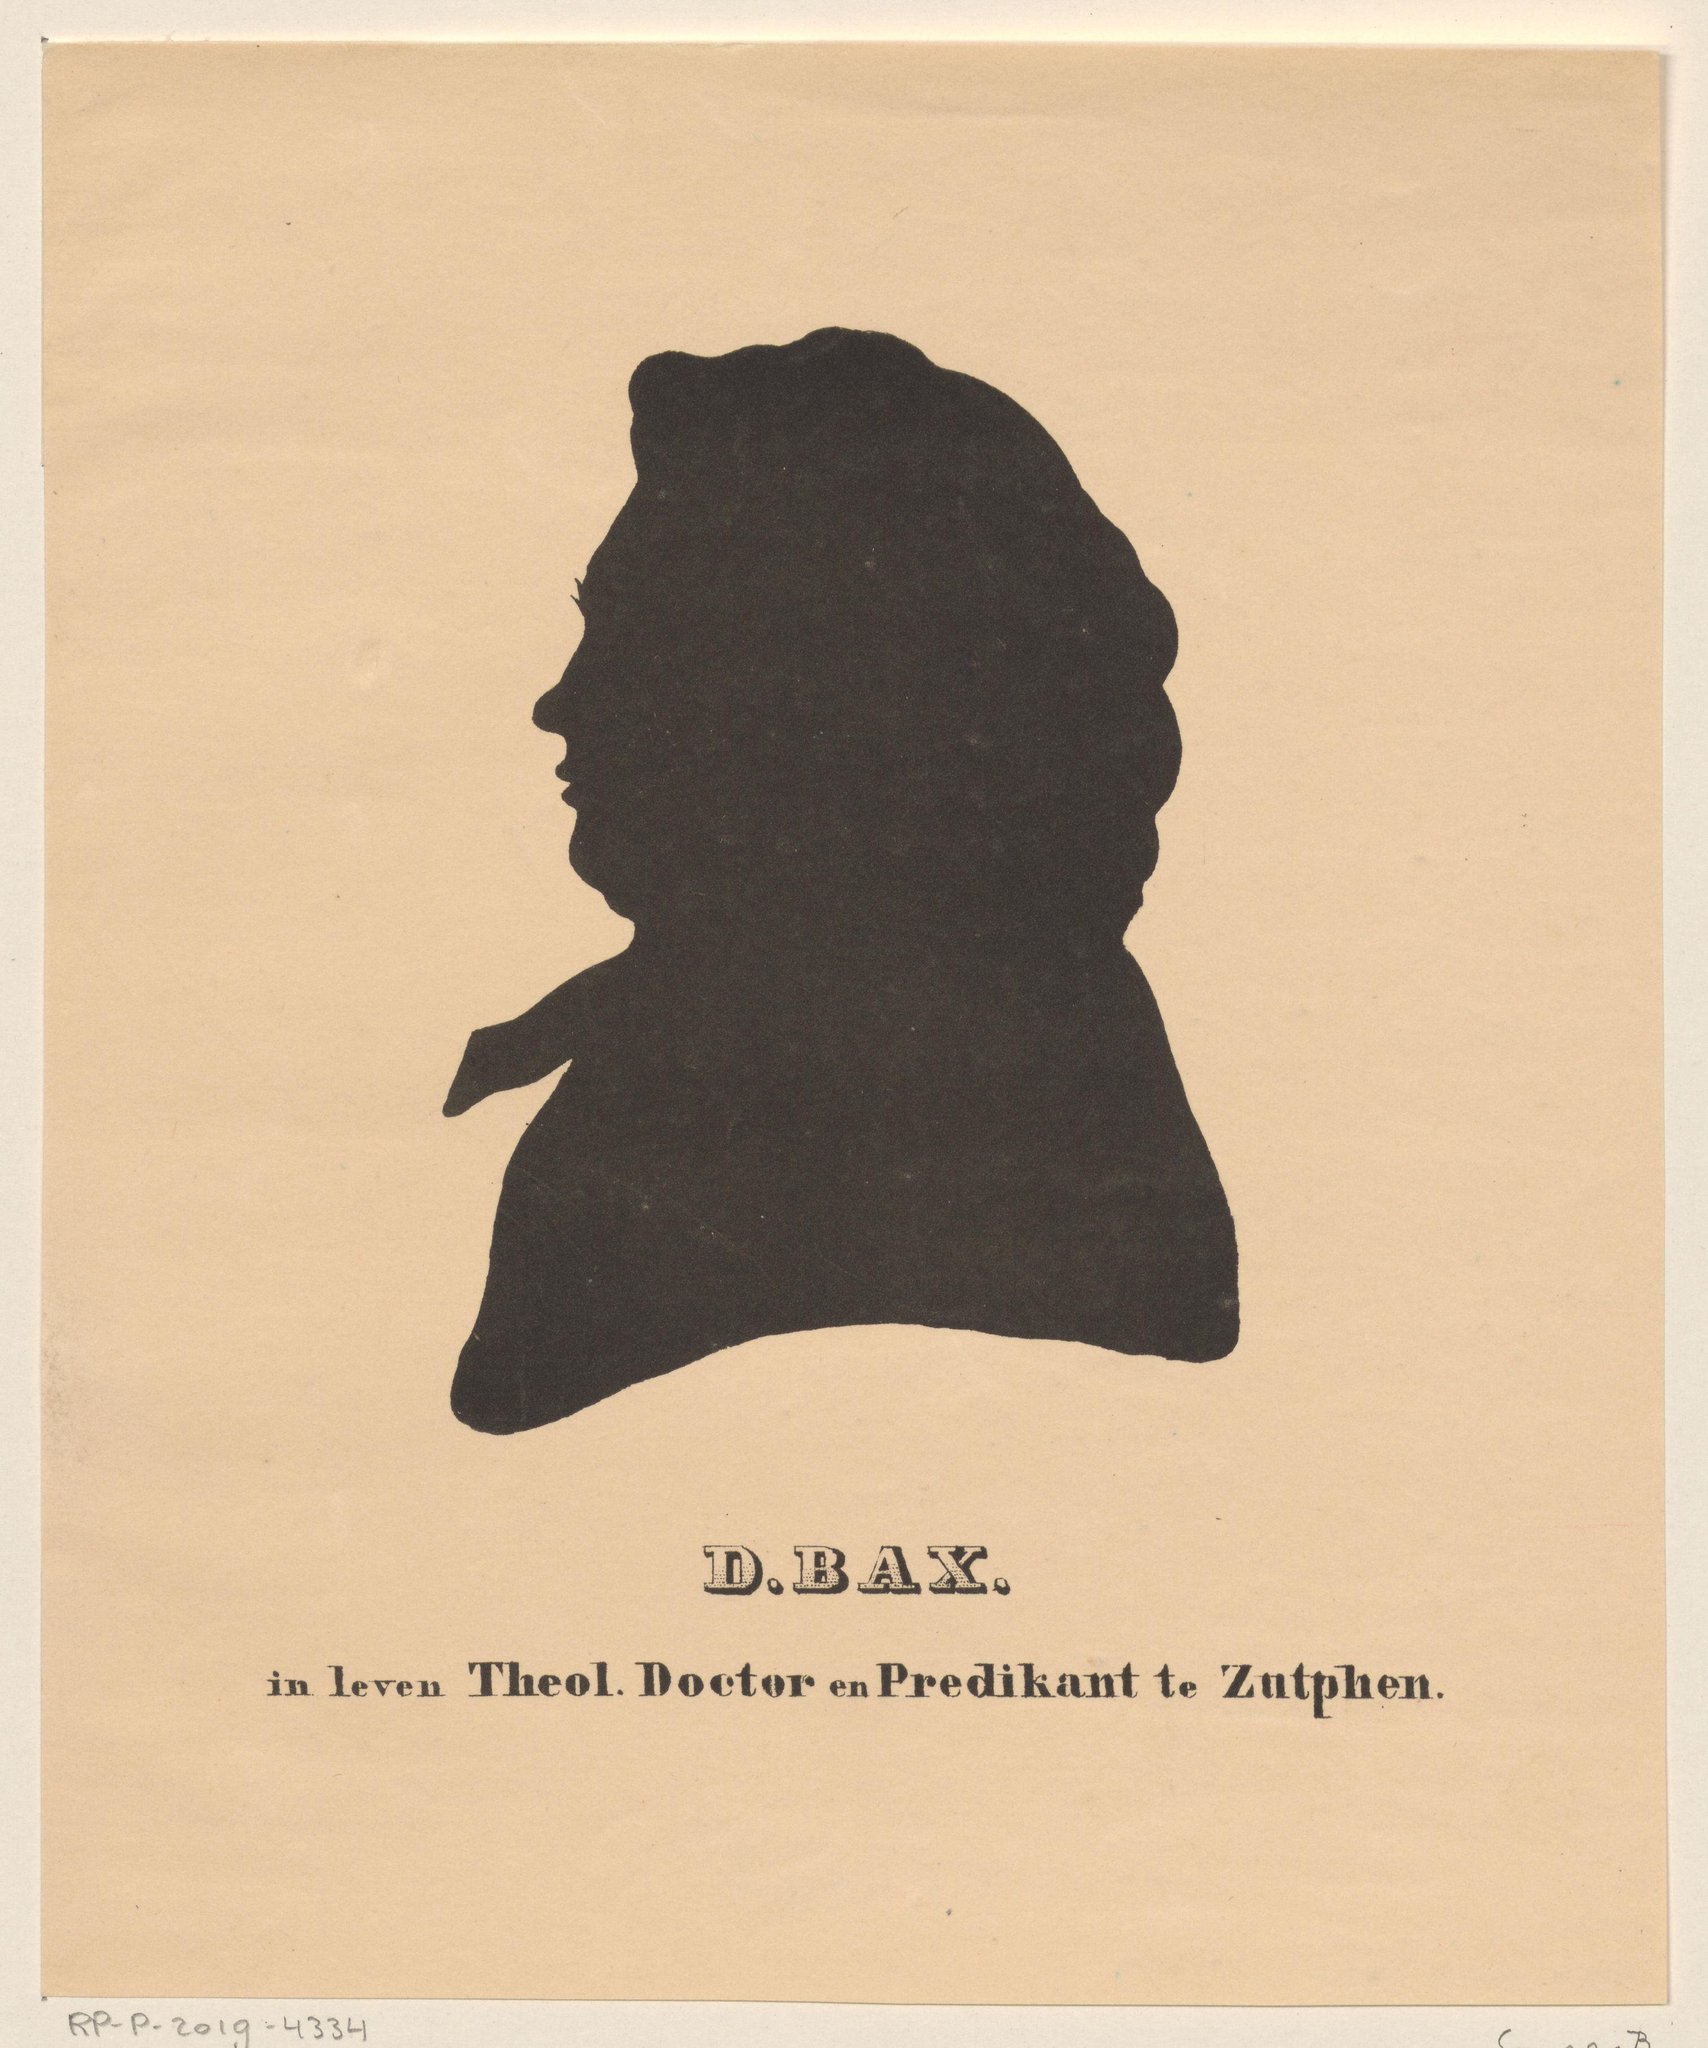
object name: print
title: Silhouetportret van Dirk Bax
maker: Anonymous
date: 1827-1849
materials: paper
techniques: lithograph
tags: historical persons